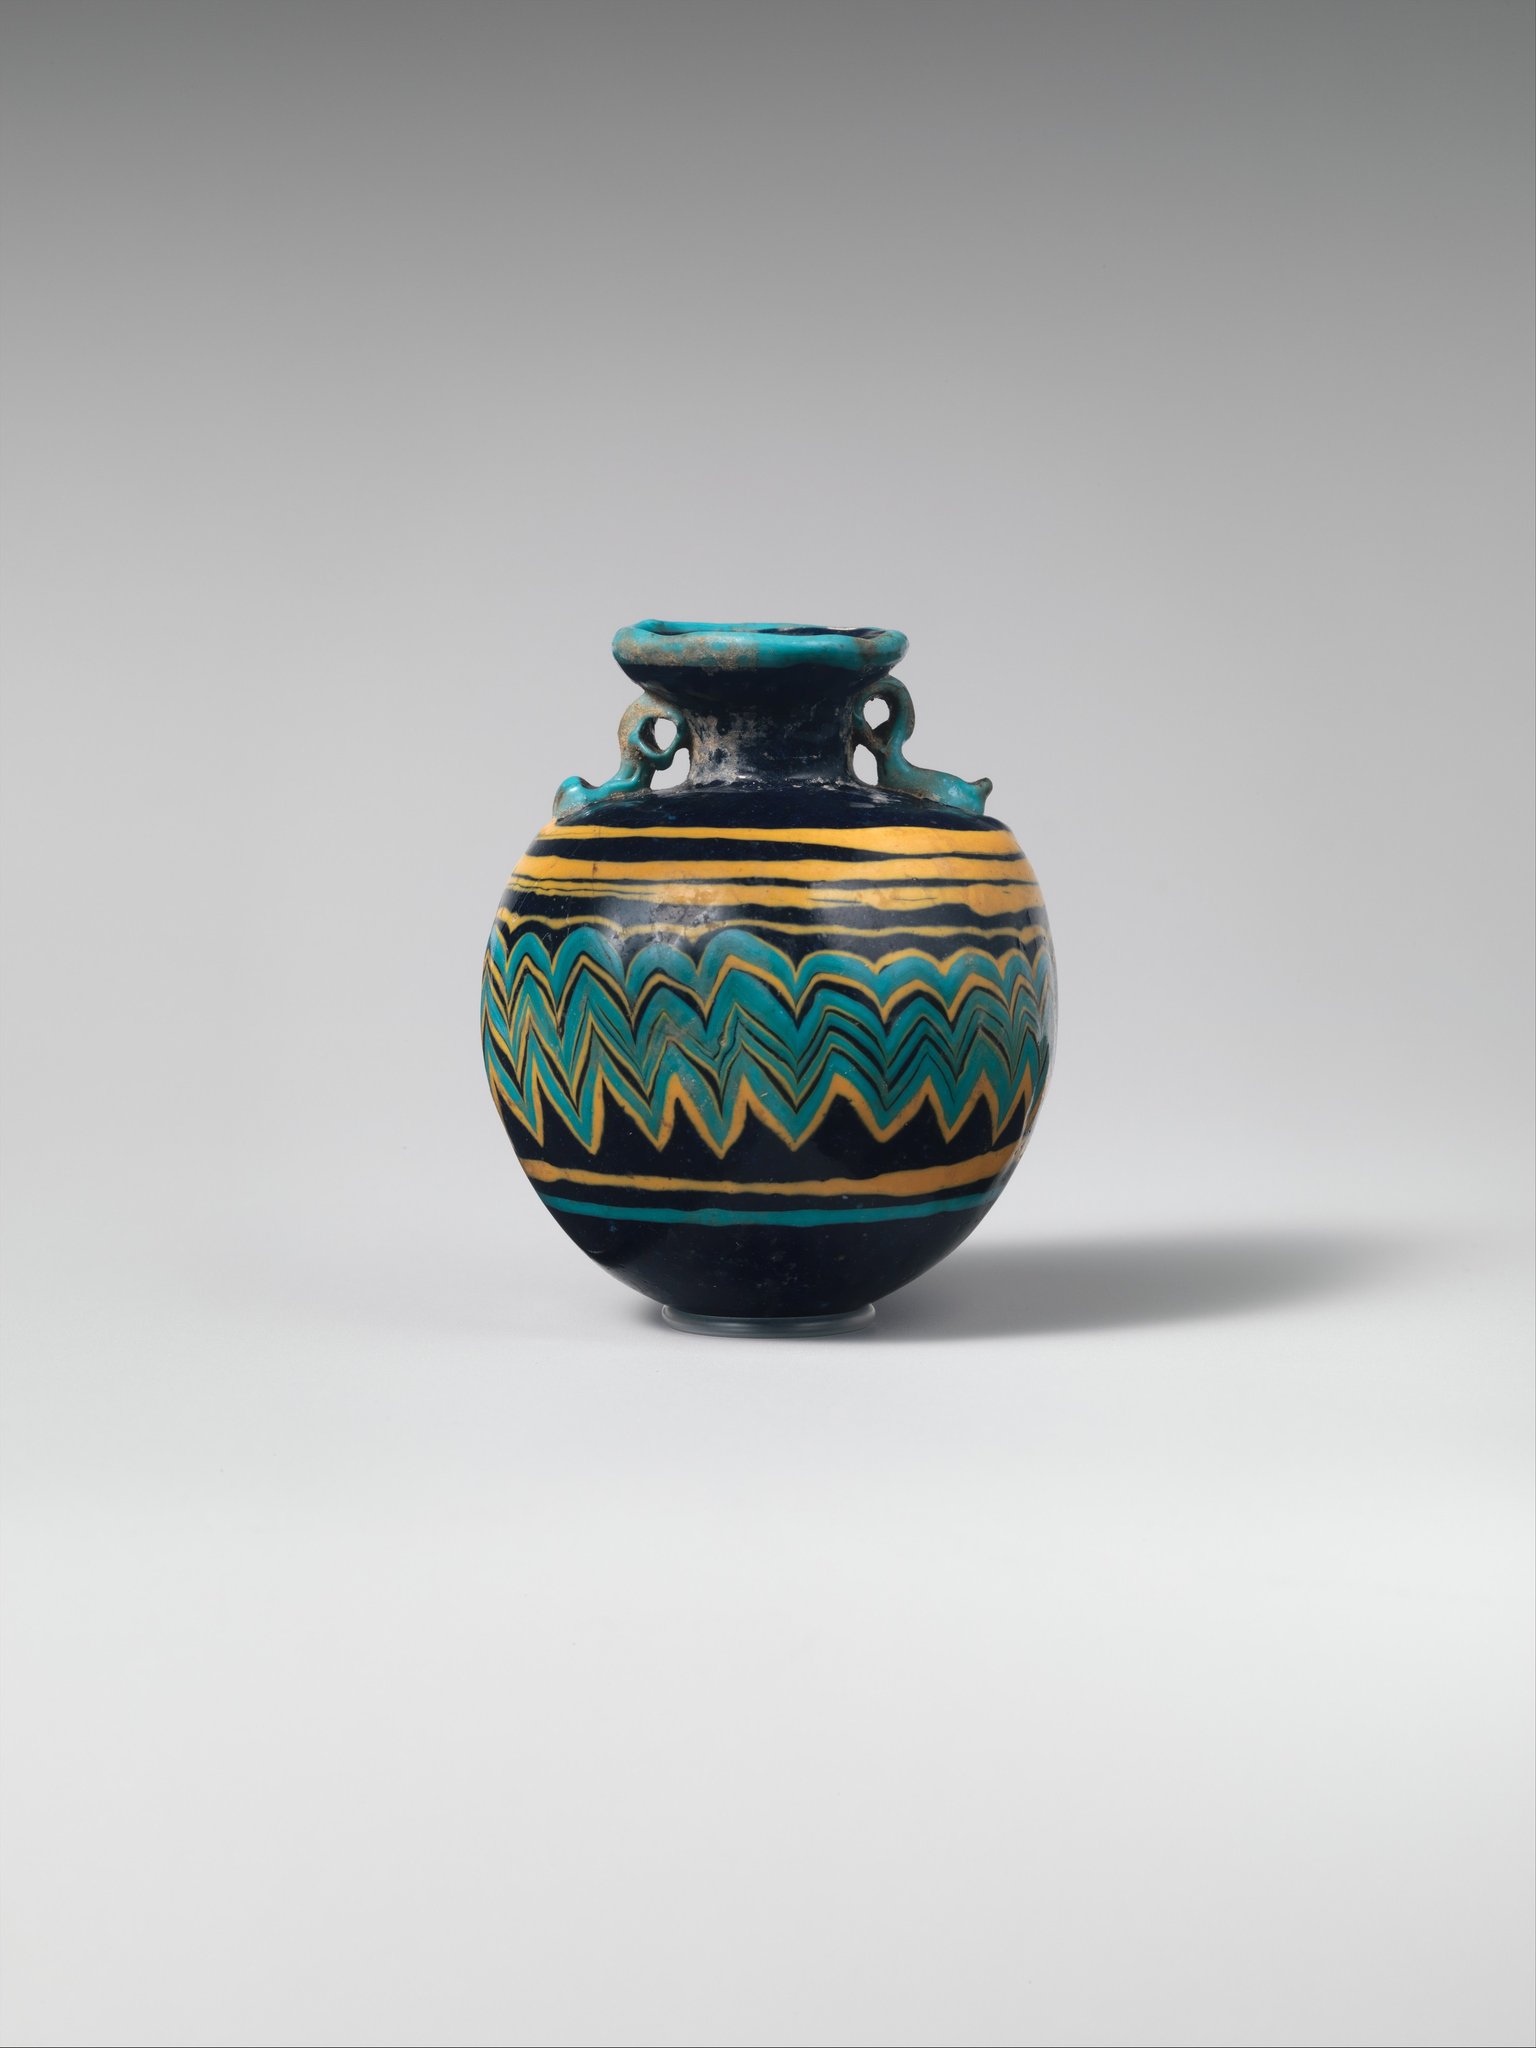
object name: aryballos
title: Glass aryballos (perfume bottle)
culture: greek, eastern mediterranean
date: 534-401 BCE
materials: glass